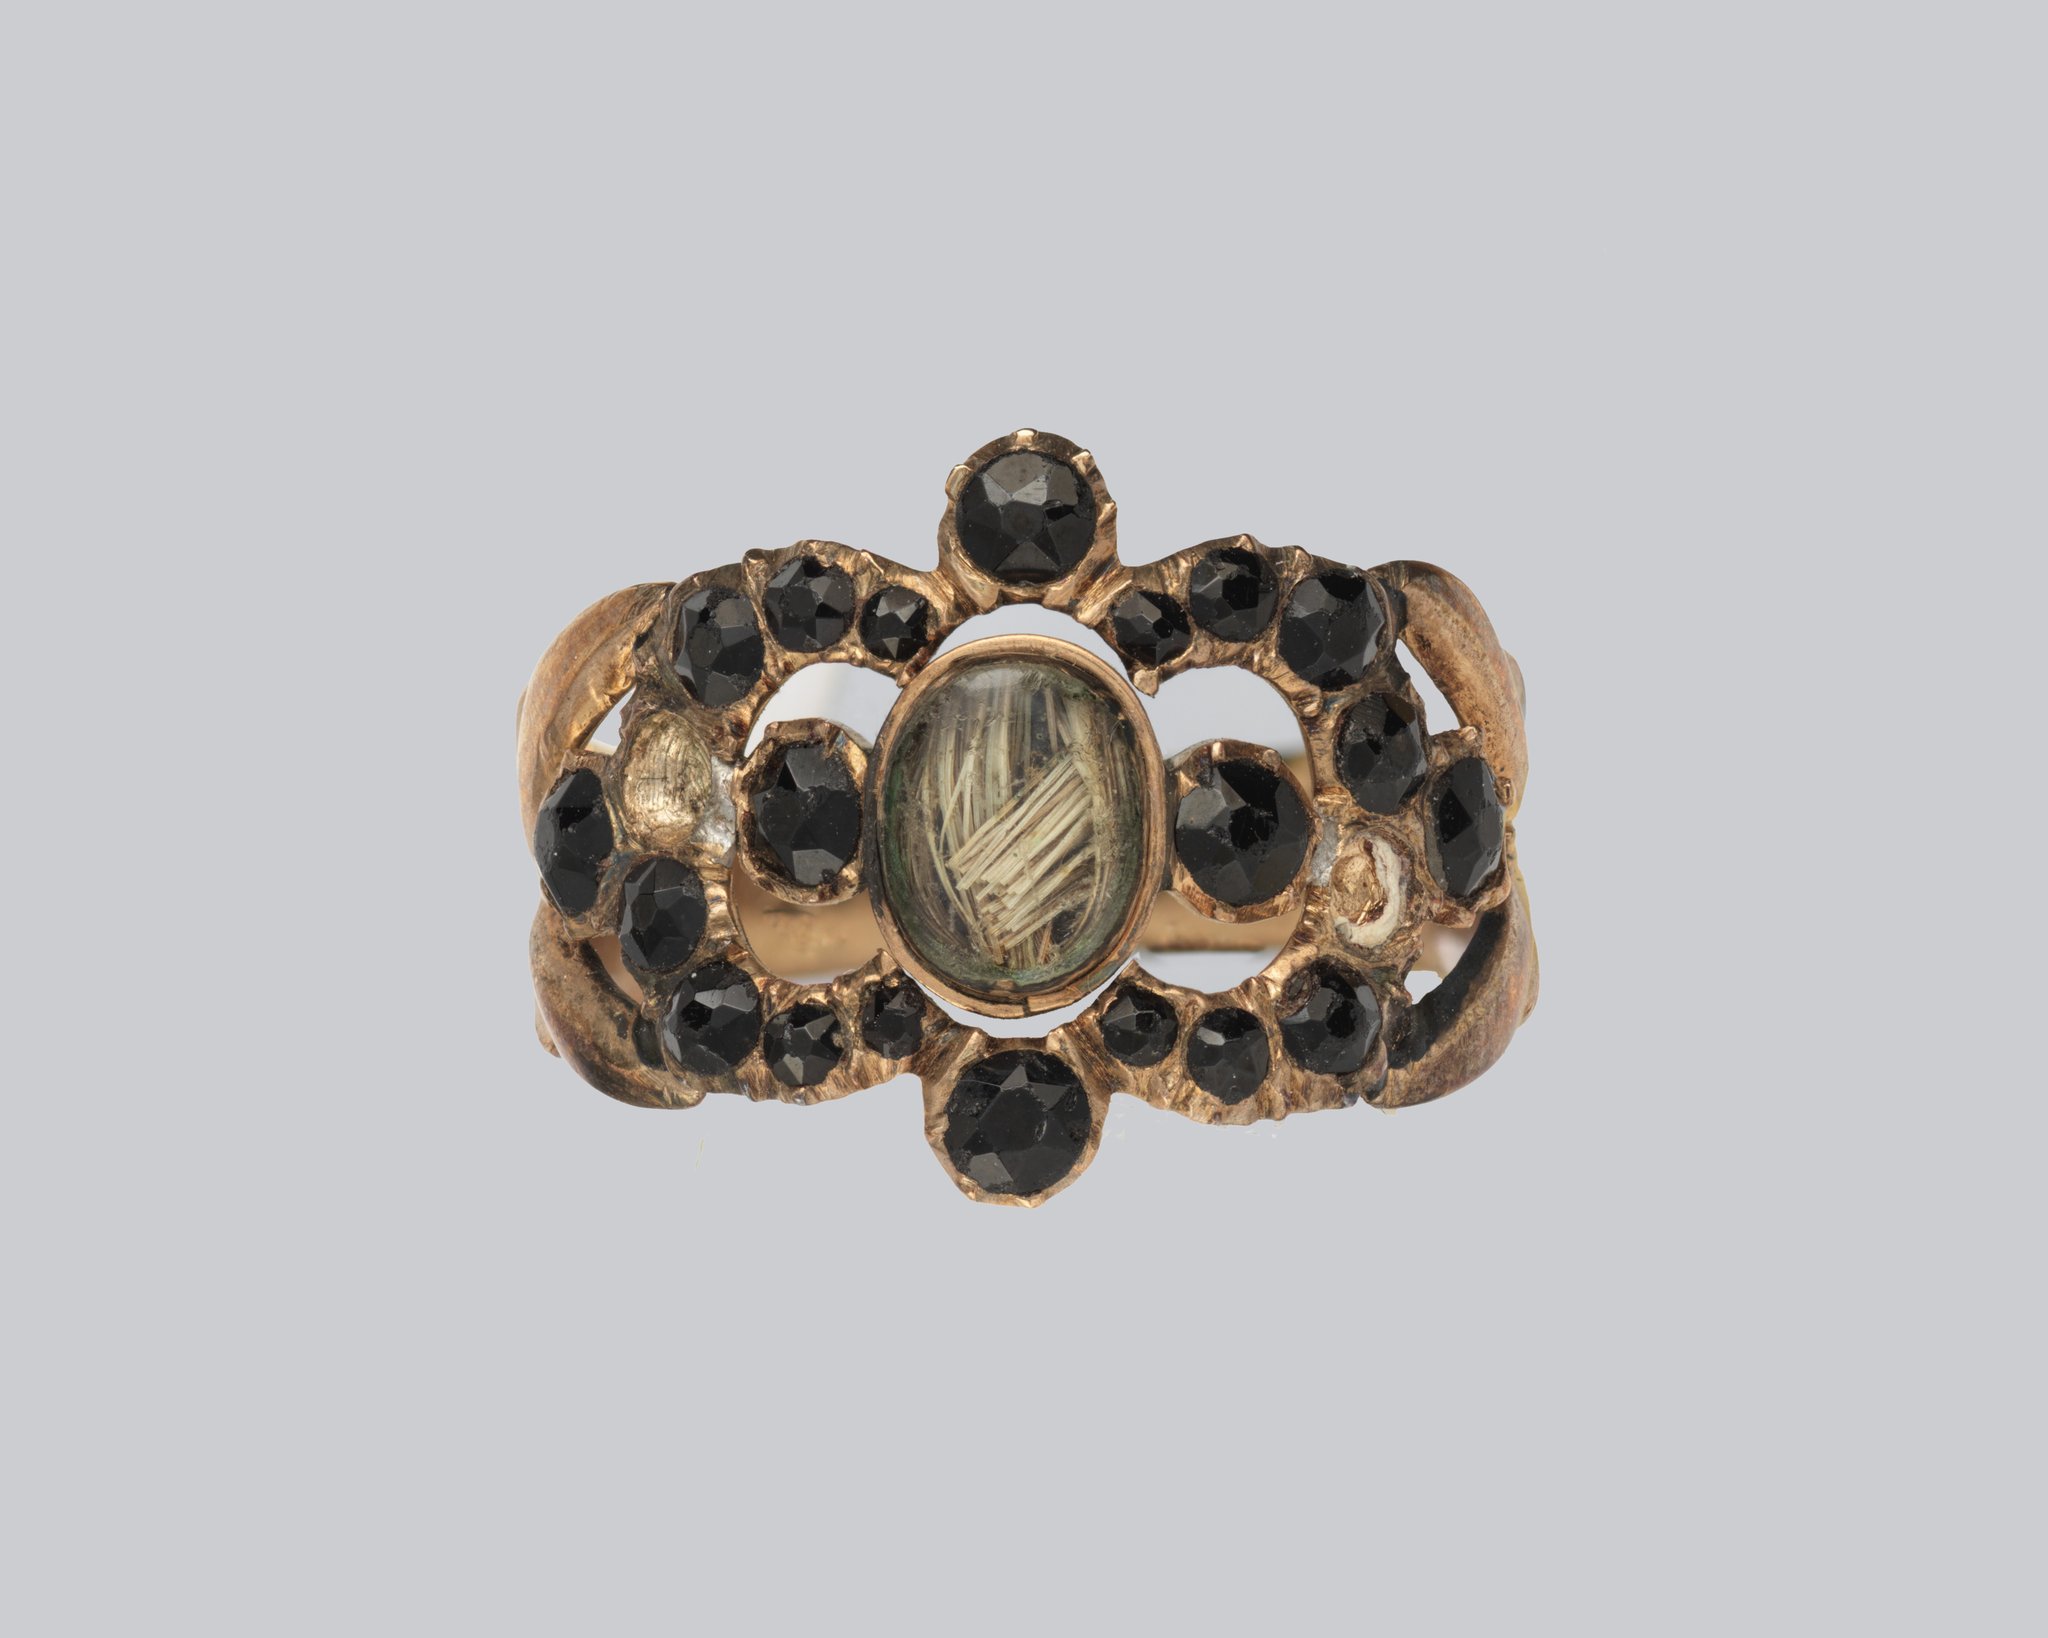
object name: ring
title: Mourning Ring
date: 1848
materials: glass, gold, hair